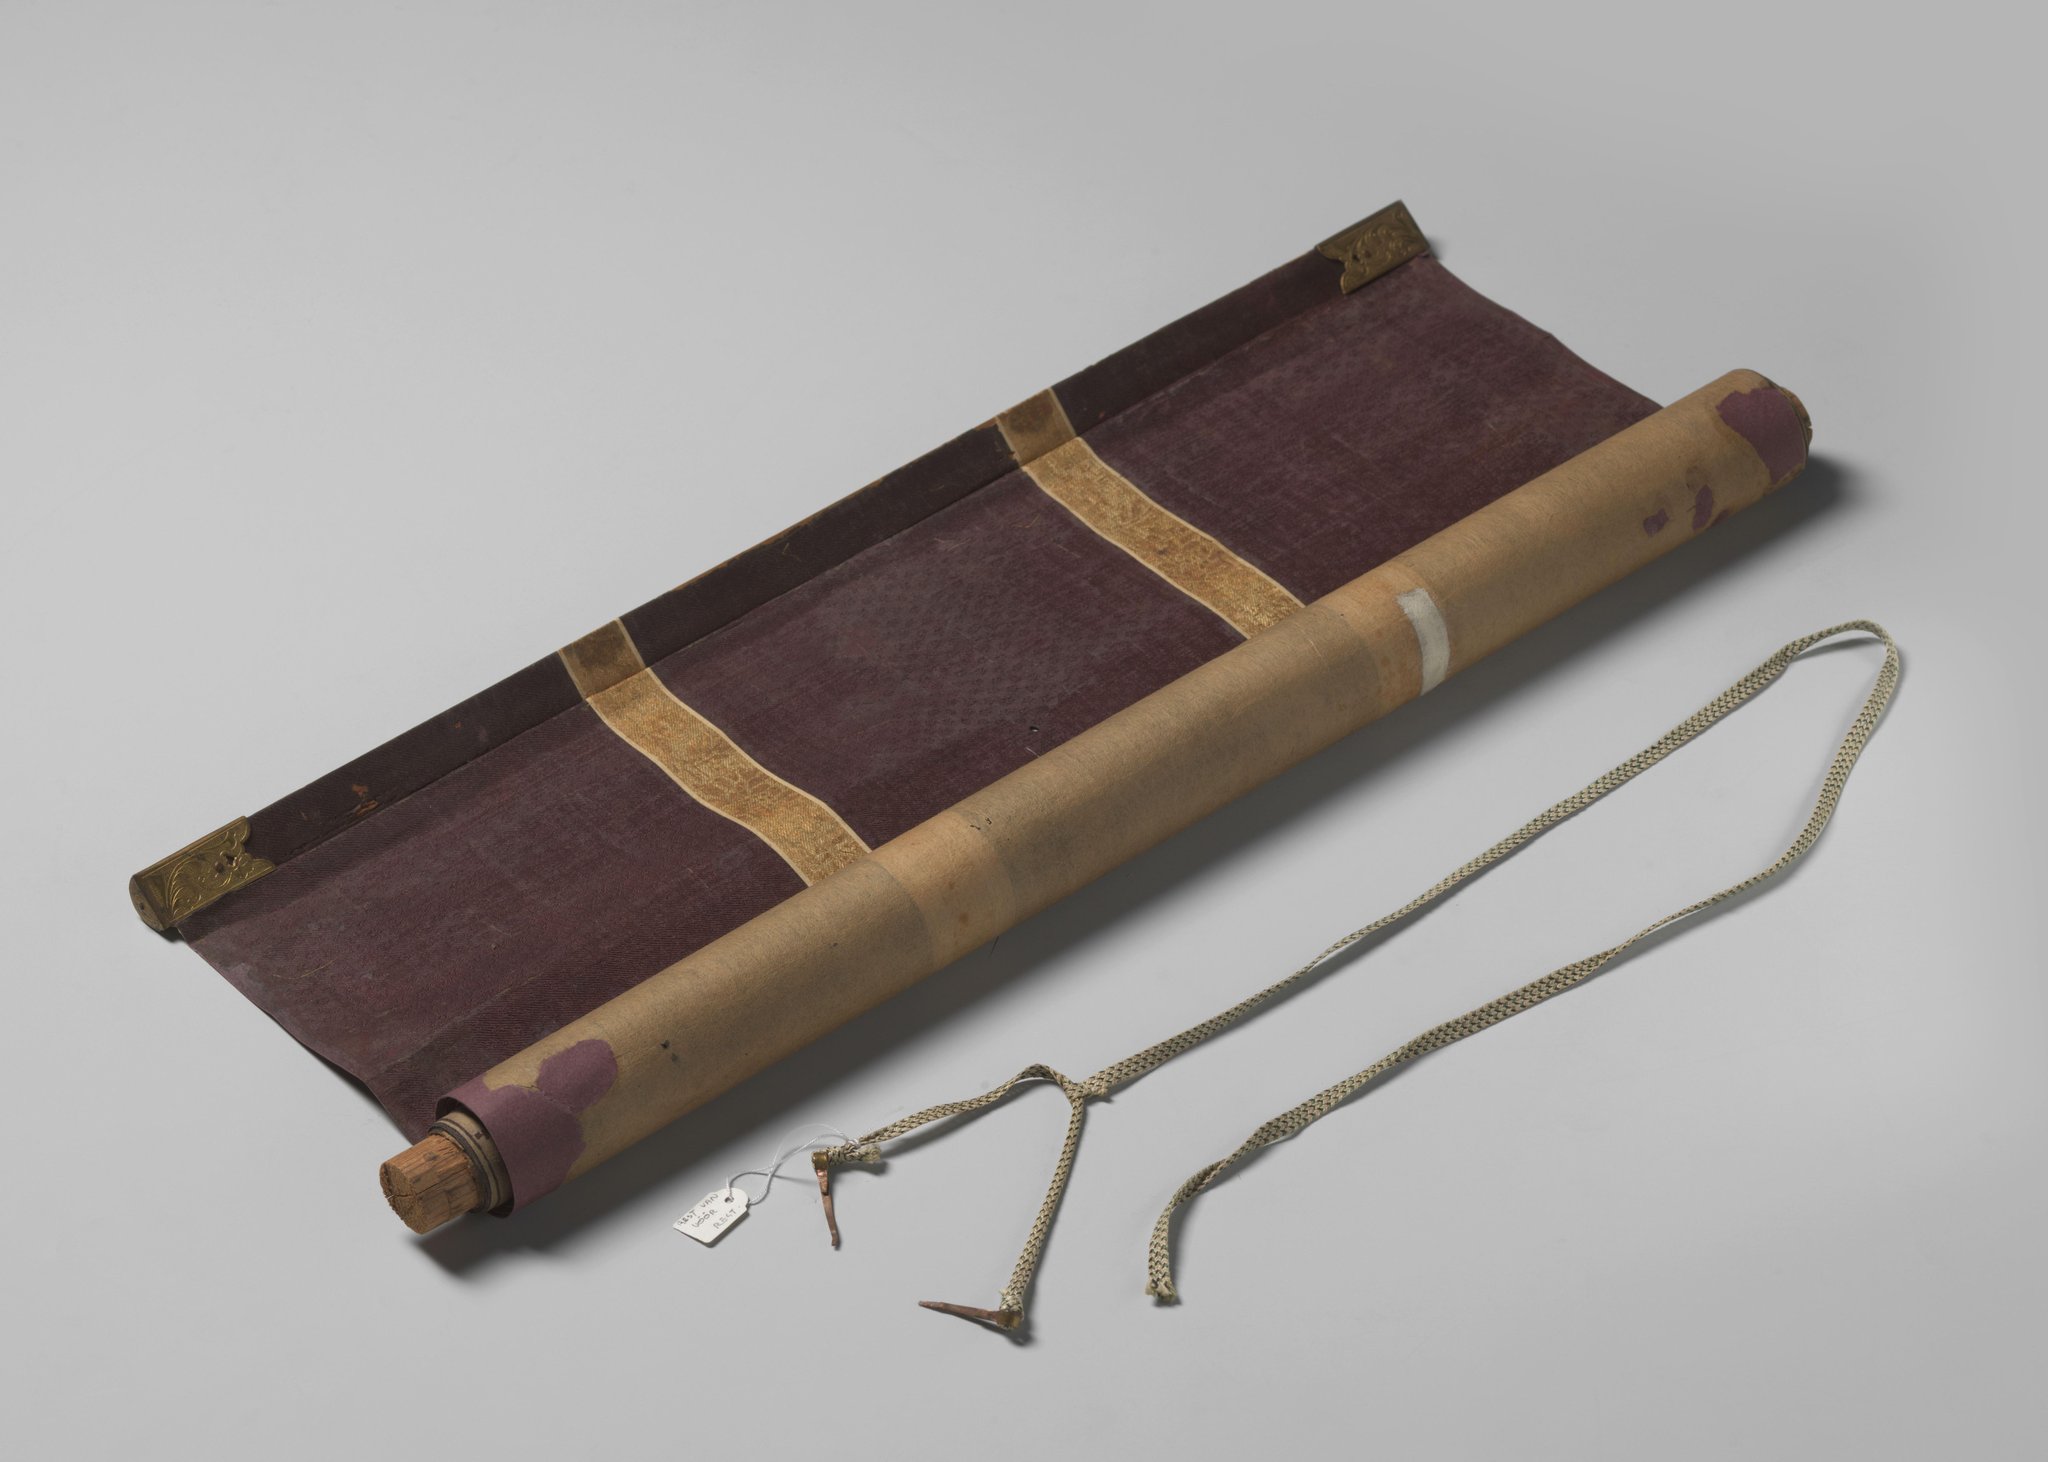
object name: passe partout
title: Jizo Bodhisattva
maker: Anonymous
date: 1300-1350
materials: paper, silk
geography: japan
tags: representations ~ gods, demi-gods, heroes, etc. (hinduism, buddhism, jainism)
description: Passe-partout of oude montering van rolschildering met de bodhisattva Jizo.